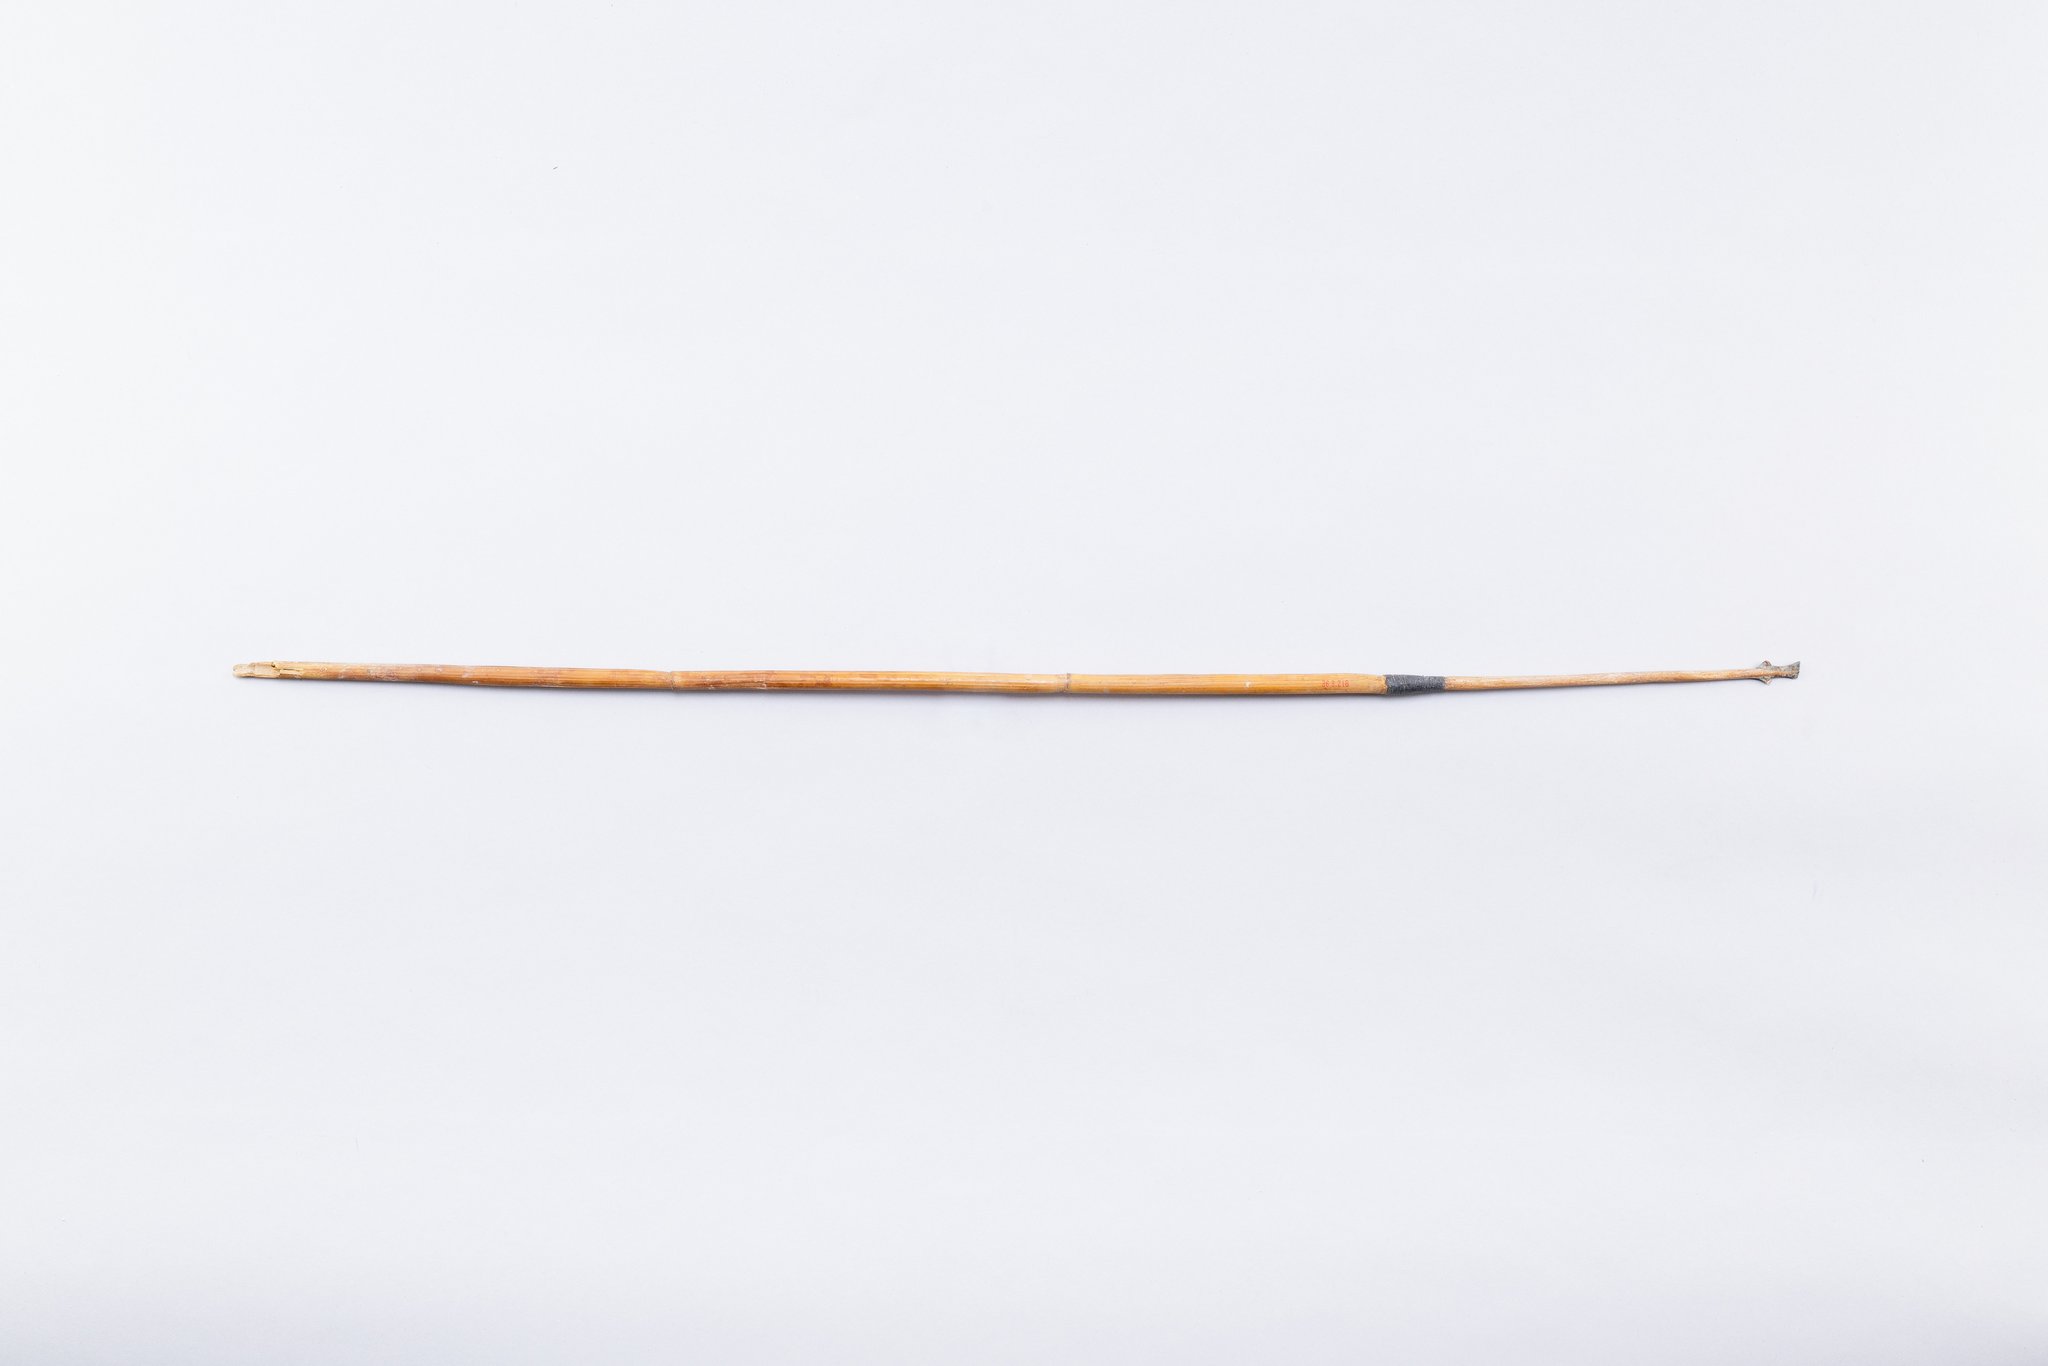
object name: arrow, arrowhead, adhesive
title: Arrow with composite stone tip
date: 1479-1458 BCE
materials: quartz, wood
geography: egypt